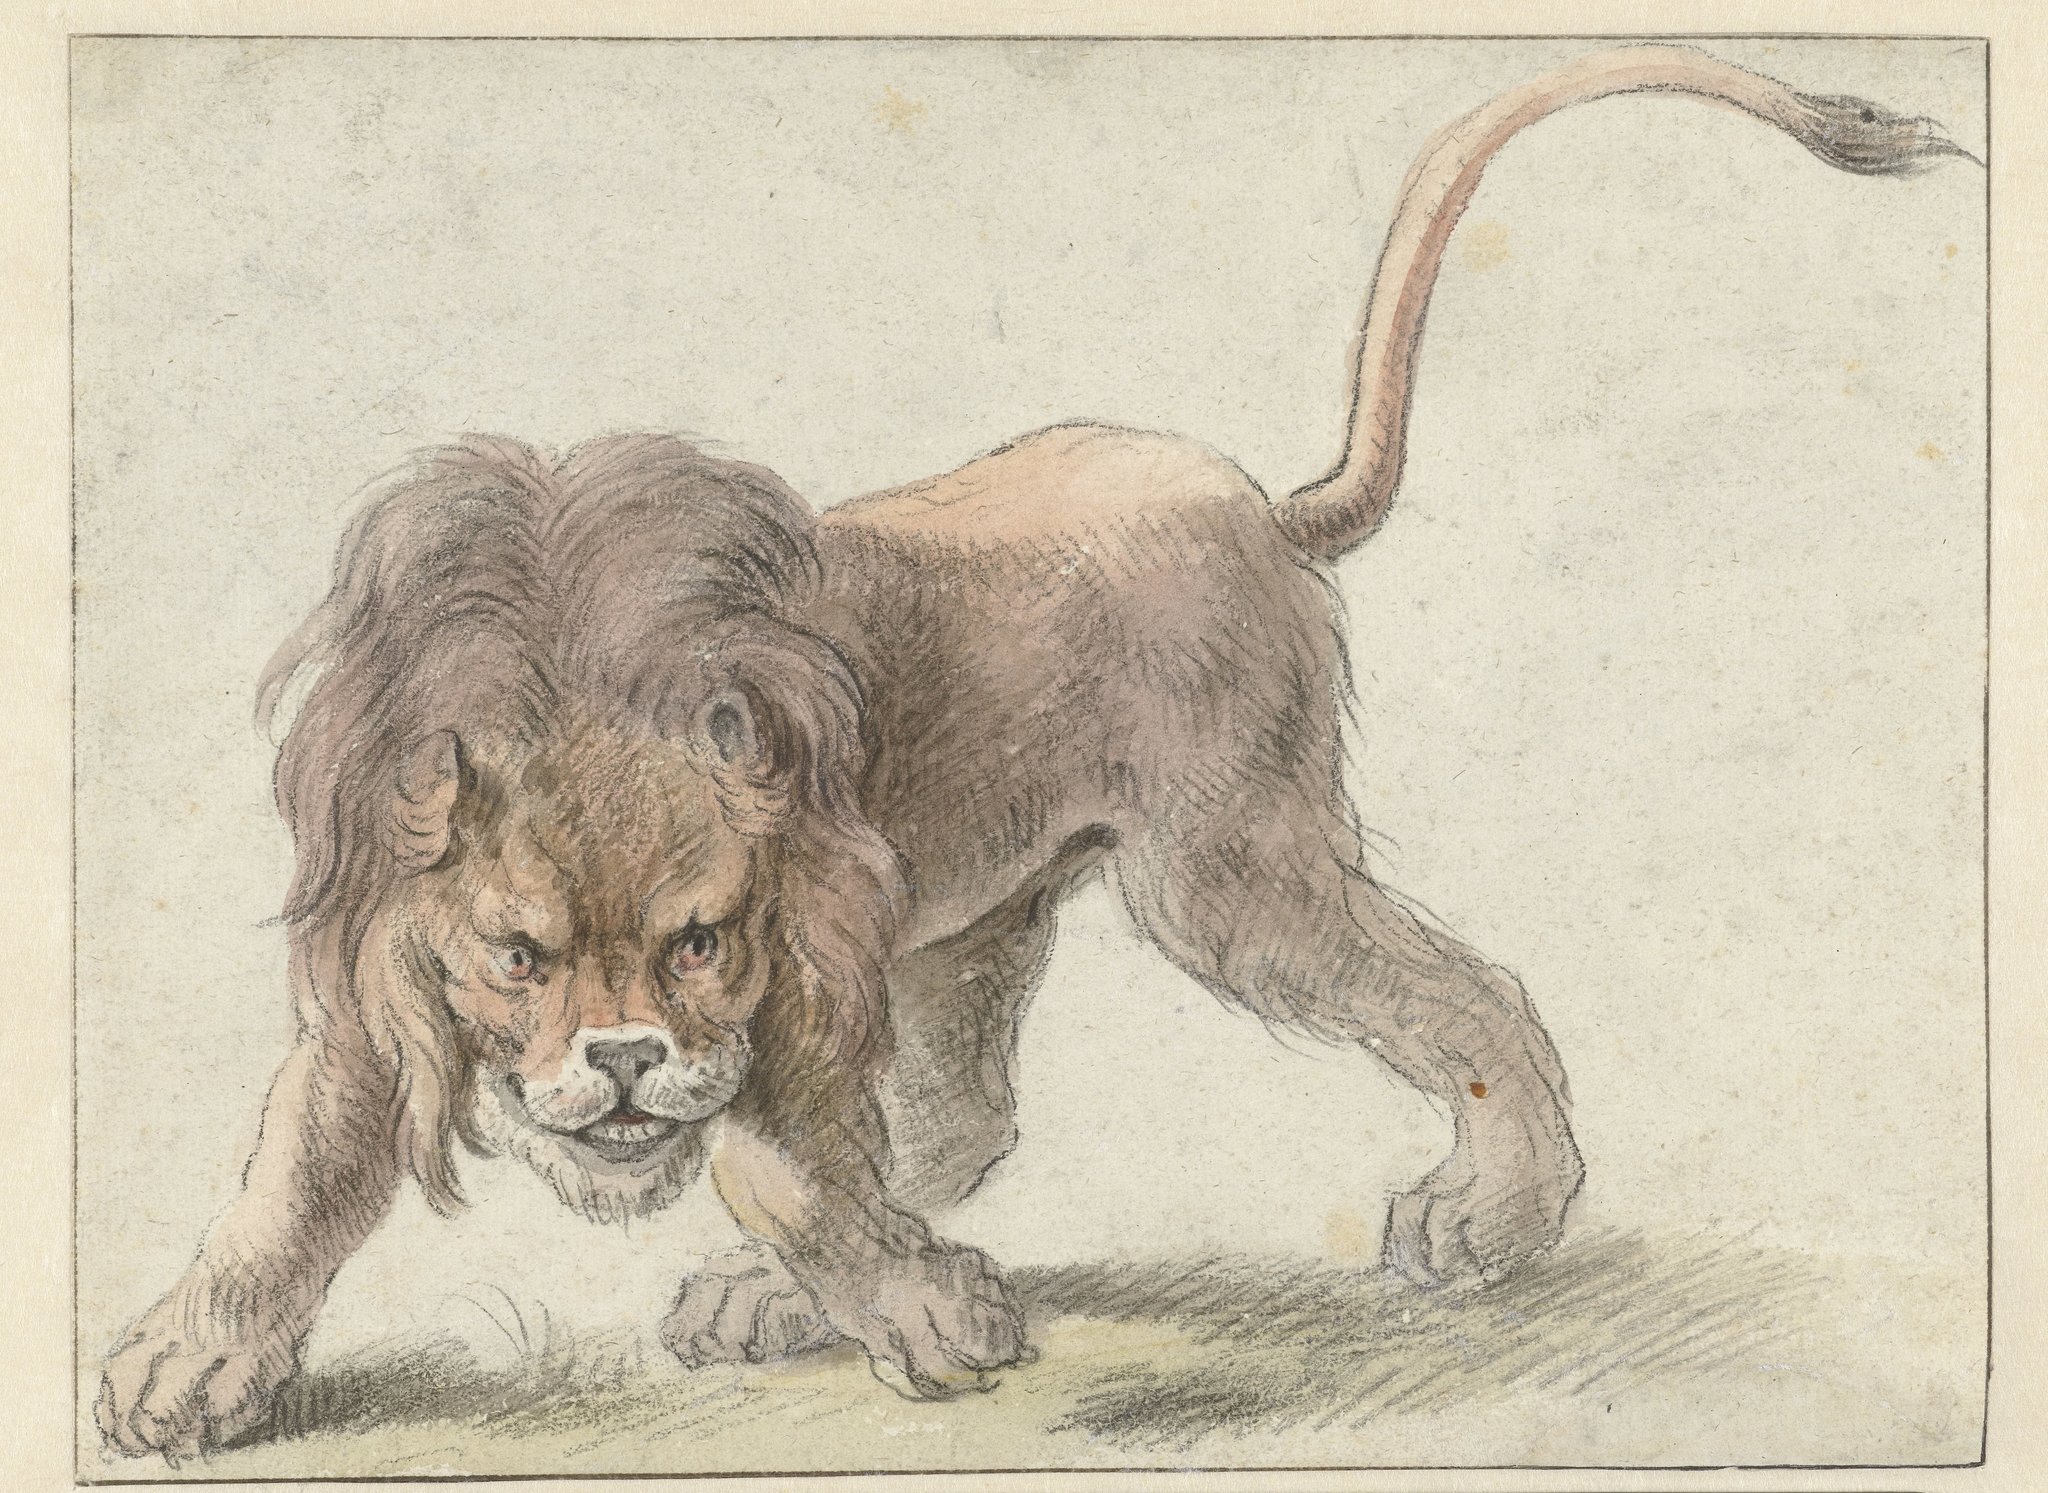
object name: drawing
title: Lion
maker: cornelis saftleven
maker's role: draughtsman, painter, print maker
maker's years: 1607-1681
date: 1620-1630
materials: chalk, paper, watercolor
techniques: brush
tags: beasts of prey, predatory animals: lion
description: Cornelis Saftleven began drawing animals from life only at a late age. Before then, he had relied on depictions by other artists, such as the animals in paintings by Roelant Savery. The lion in this drawing also seems to have been taken from such an example. The animal’s pose looks unnatural and its head more closely resembles that of a dog.